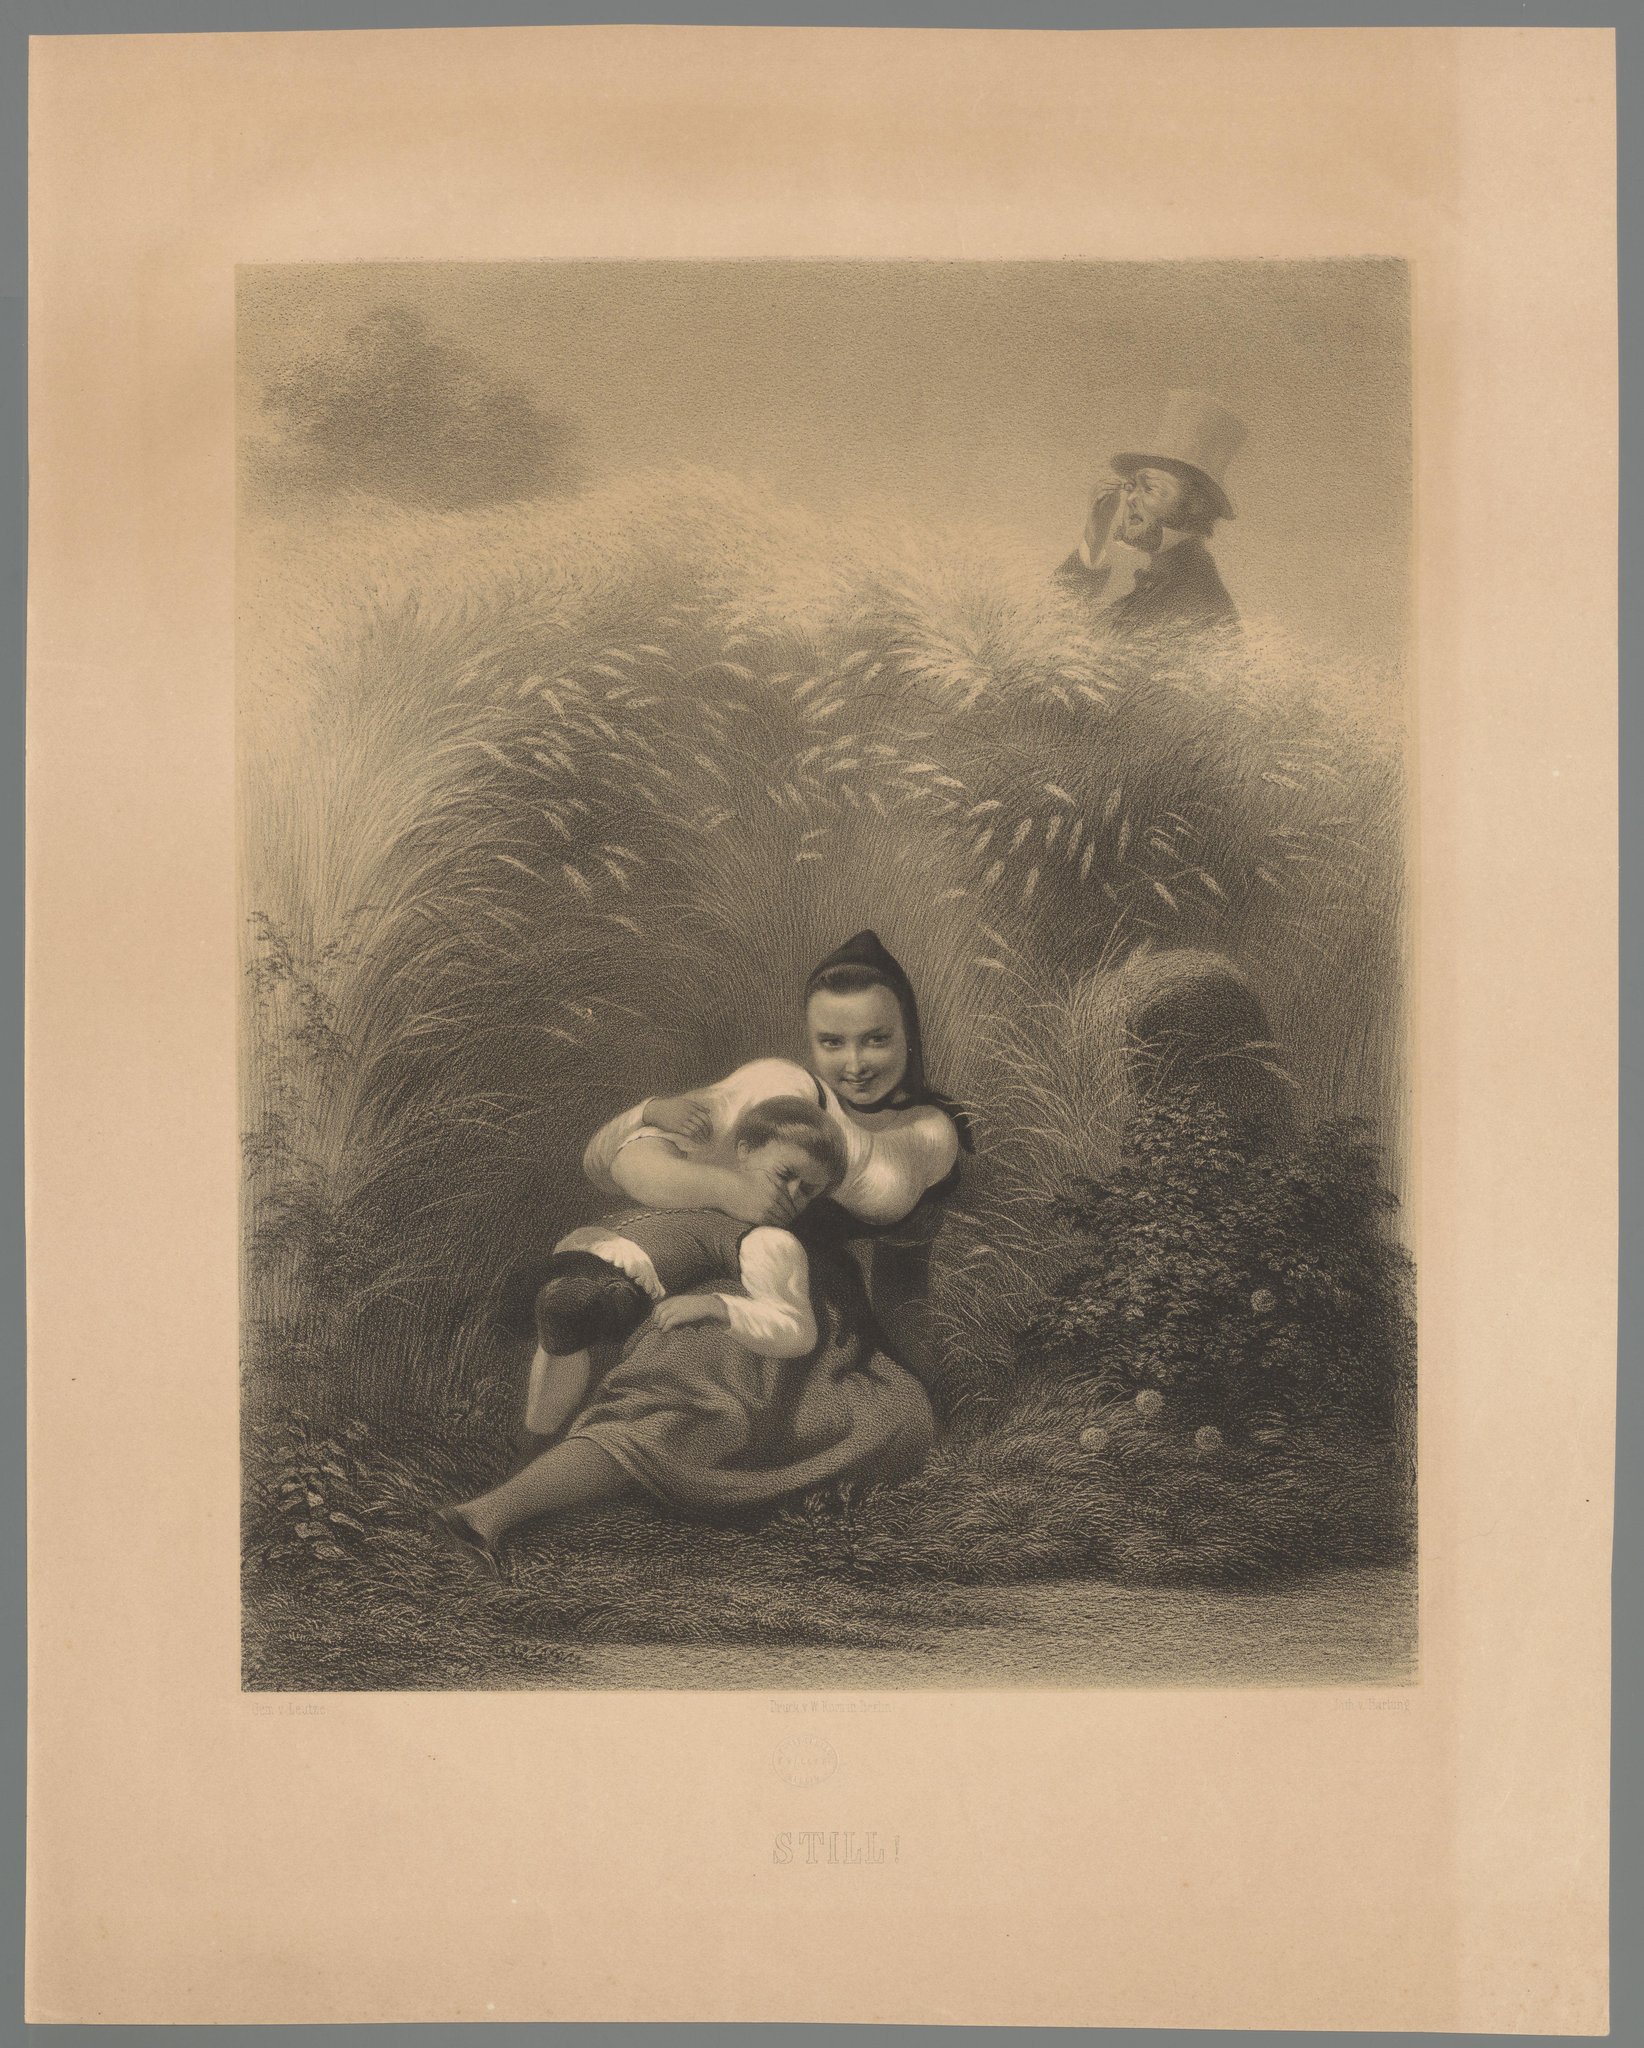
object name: print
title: Still!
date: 1830-1880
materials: paper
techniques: tone lithography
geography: berlin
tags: hiding, hiding oneself, being silent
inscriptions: collector's mark: Lugt 2228, check stamp: ‘Kunst-Verlag F. Sala & Co Berlin’